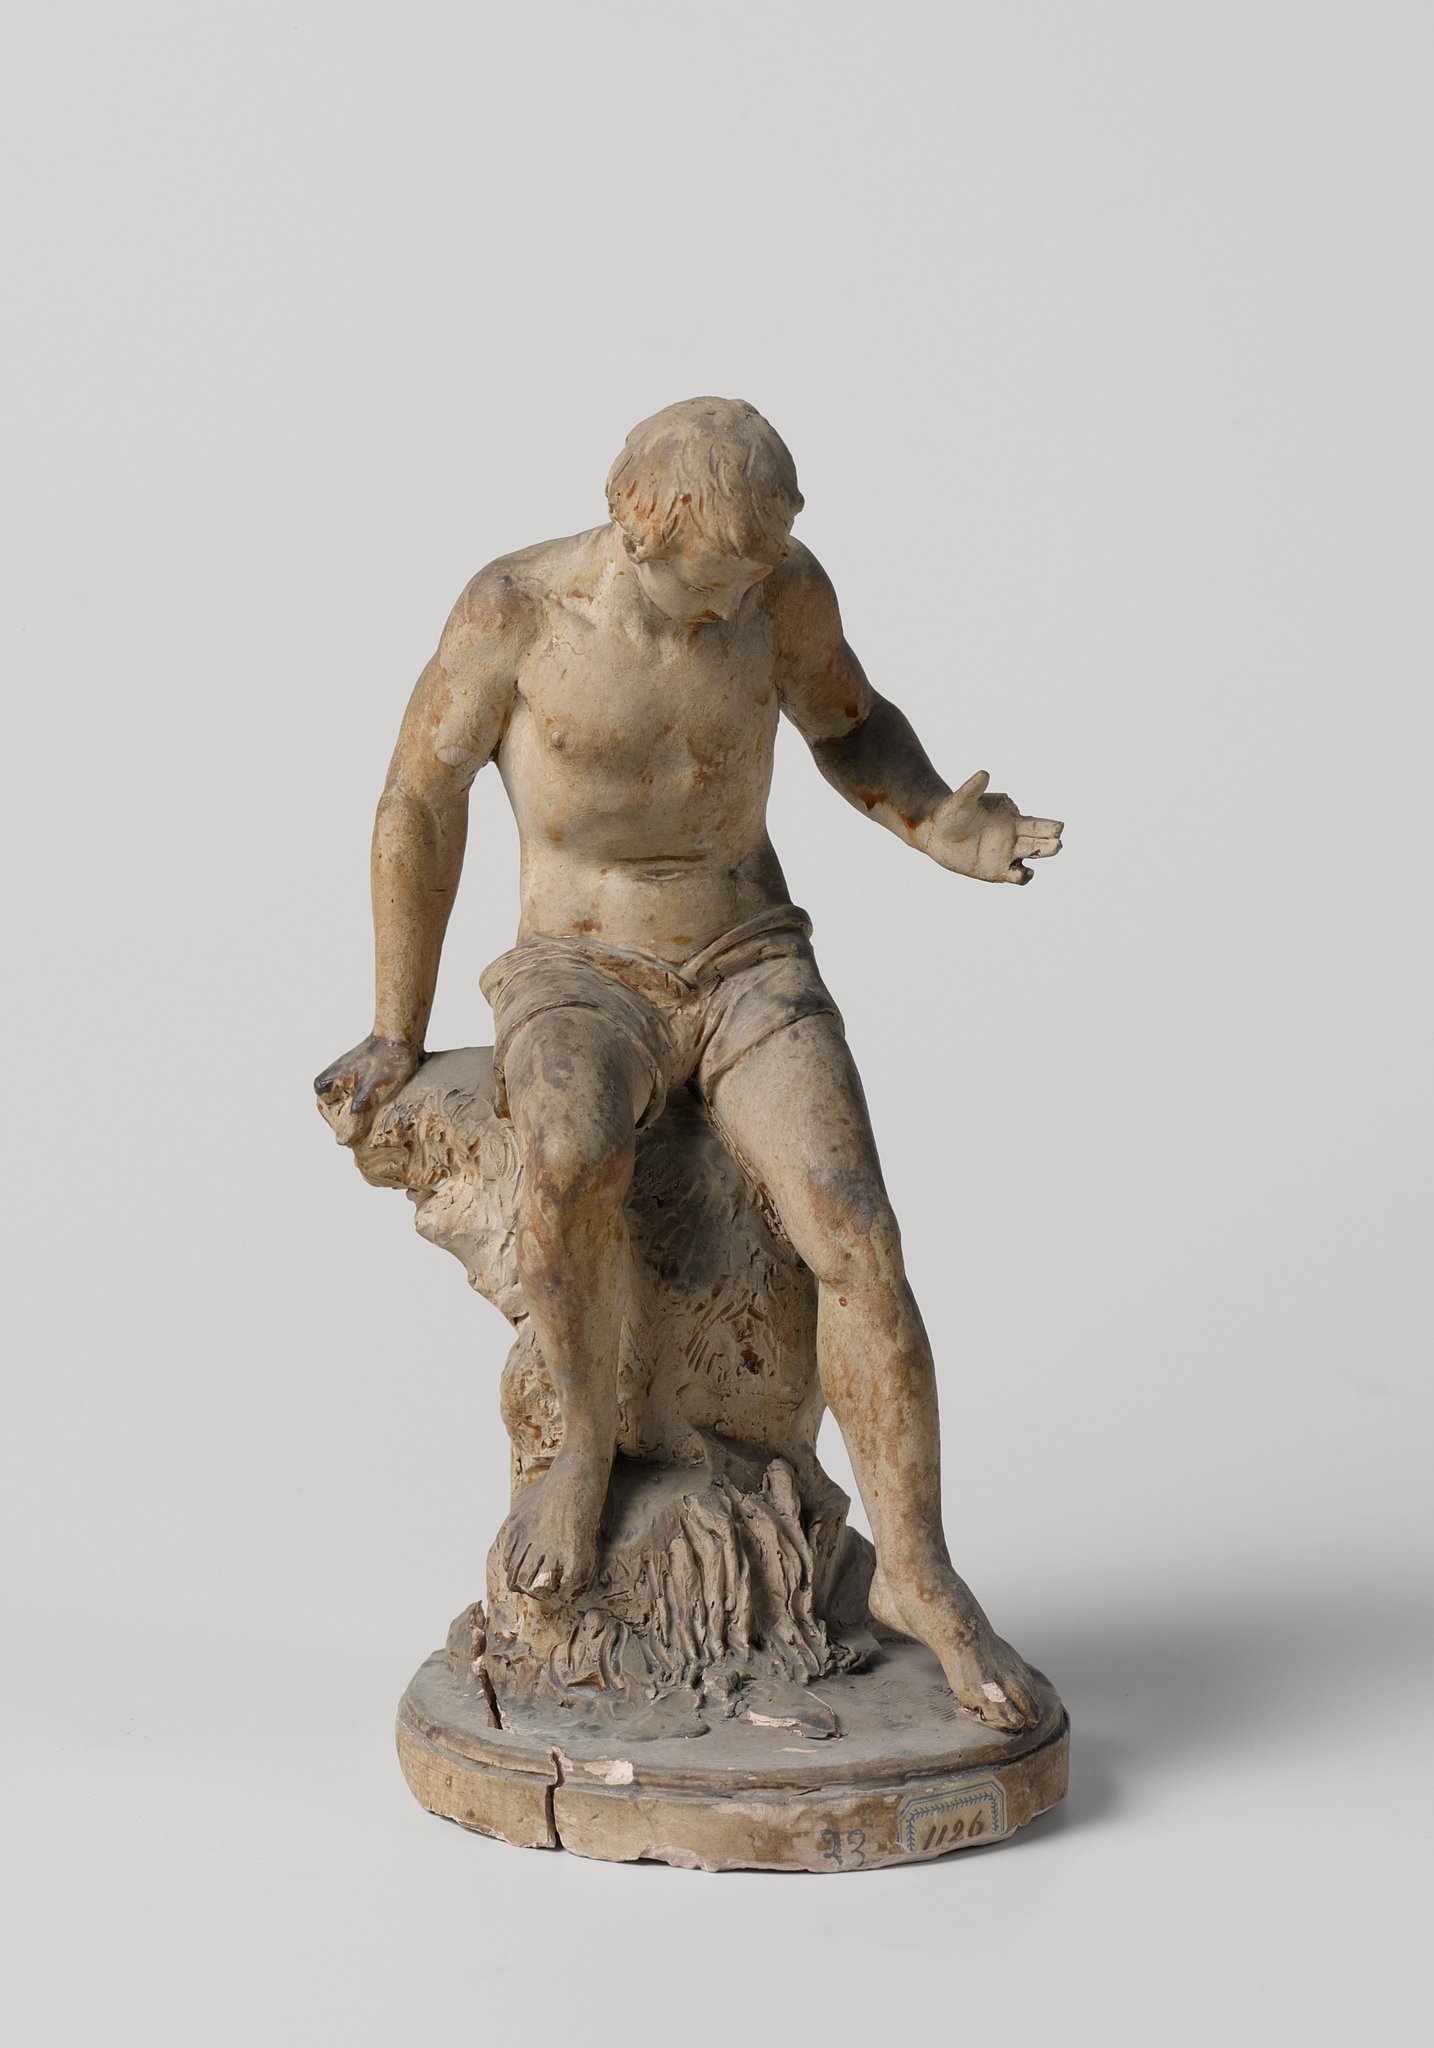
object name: base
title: Badende jongeling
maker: eugène lacomblé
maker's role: draughtsman, painter, sculptor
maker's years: 1828-1905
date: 1875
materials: terracotta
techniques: modeling